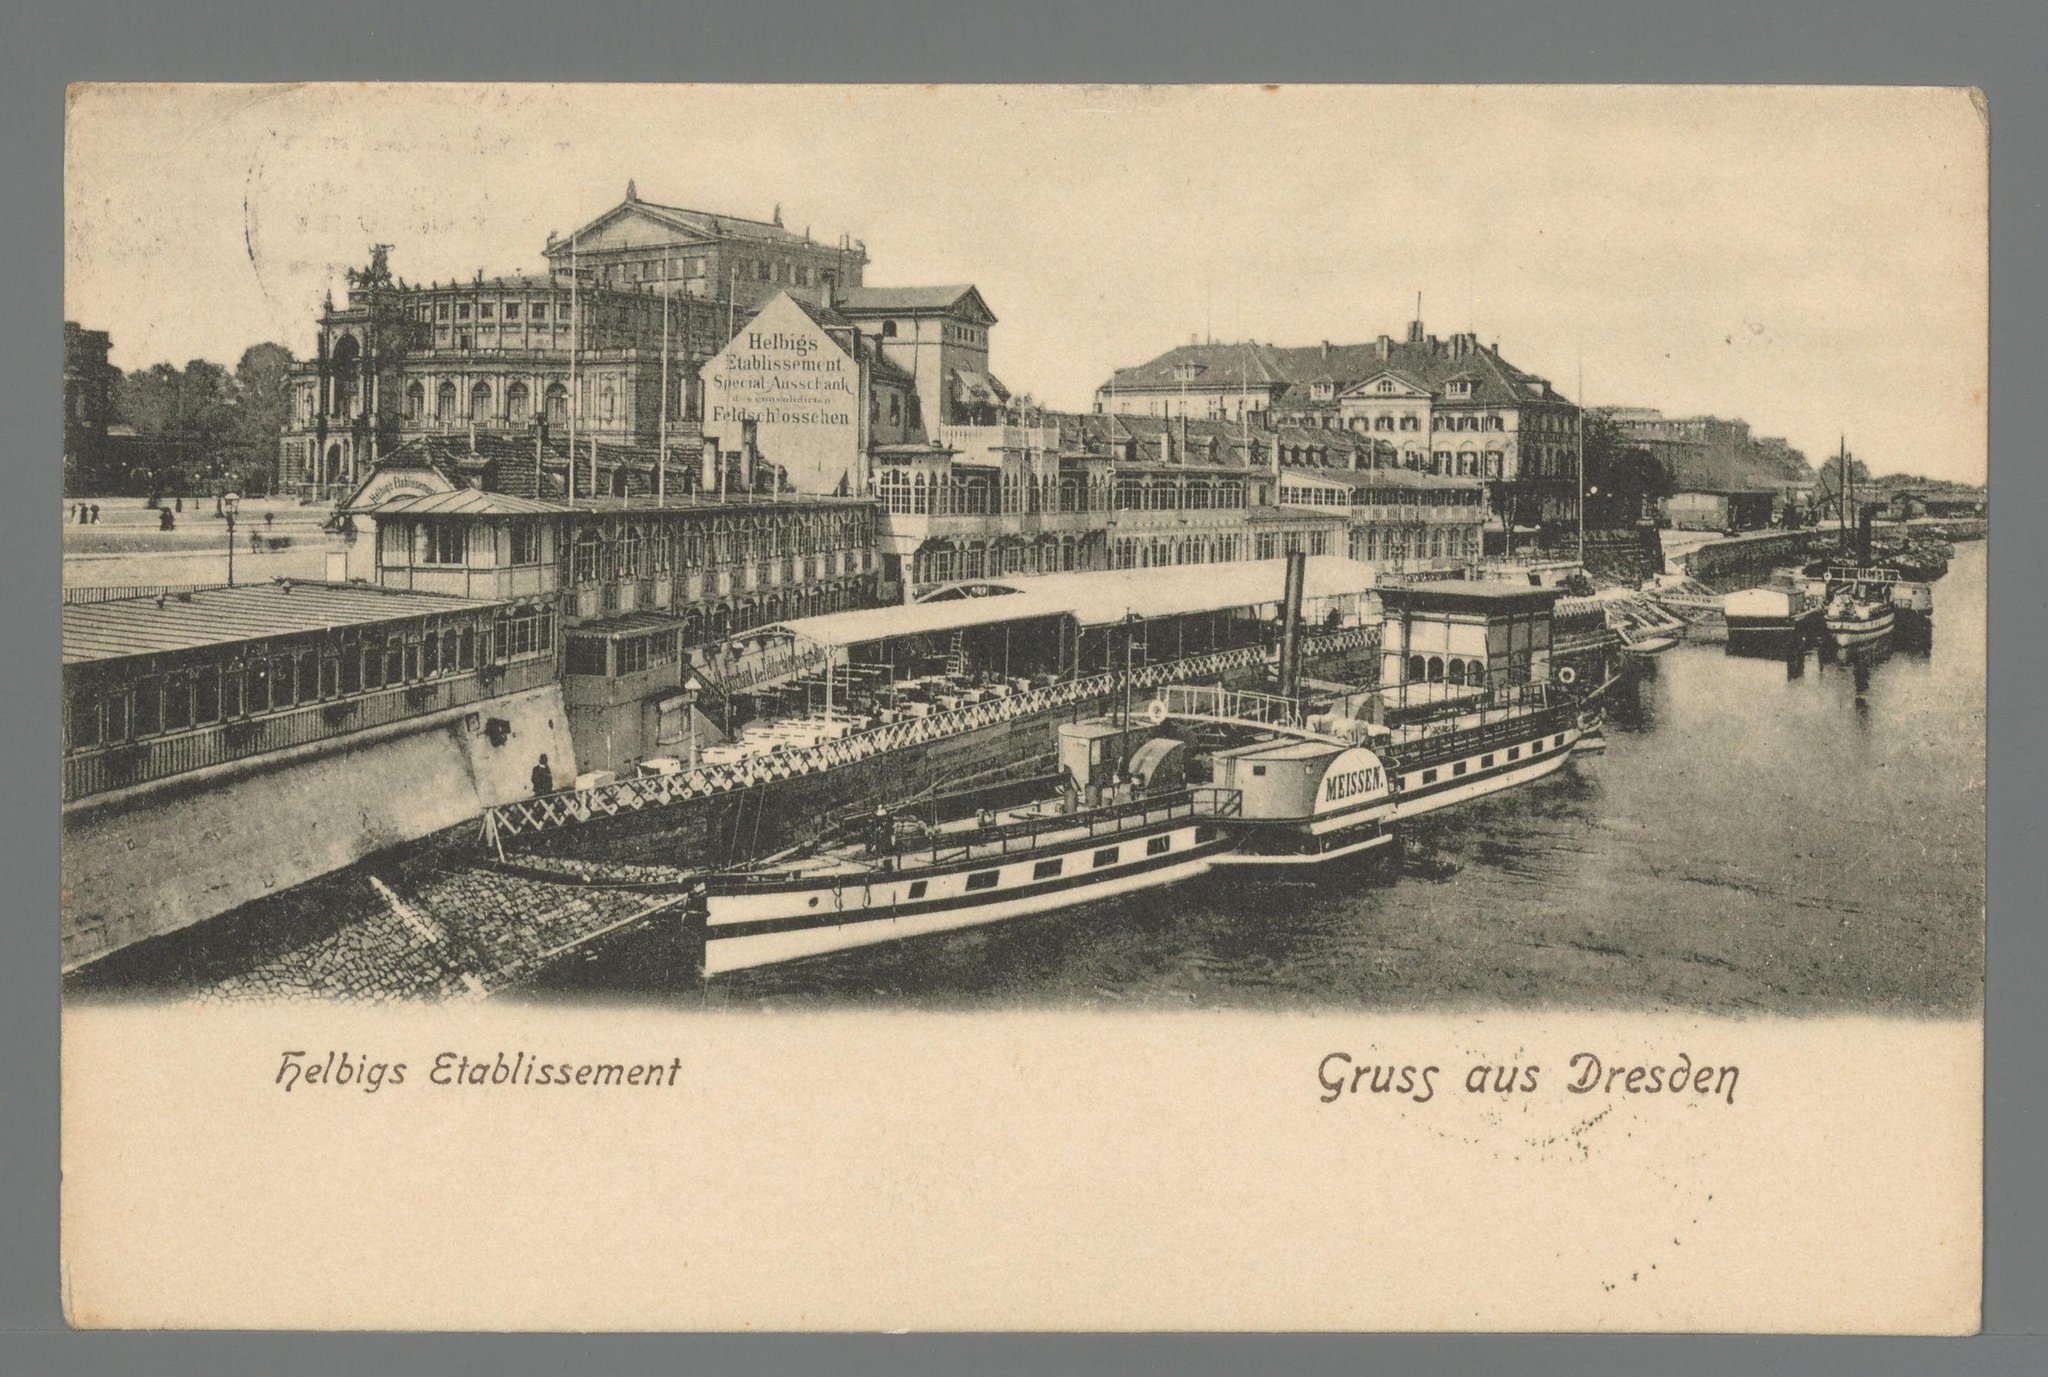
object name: photomechanical print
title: Helbigs Etablissement. Gruss aus Dresden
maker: Anonymous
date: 1885-1905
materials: cardboard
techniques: photograph, writing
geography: dresden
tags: city-view, and landscape with man-made constructions, canals, waters (in city), restaurant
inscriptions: postage stamp